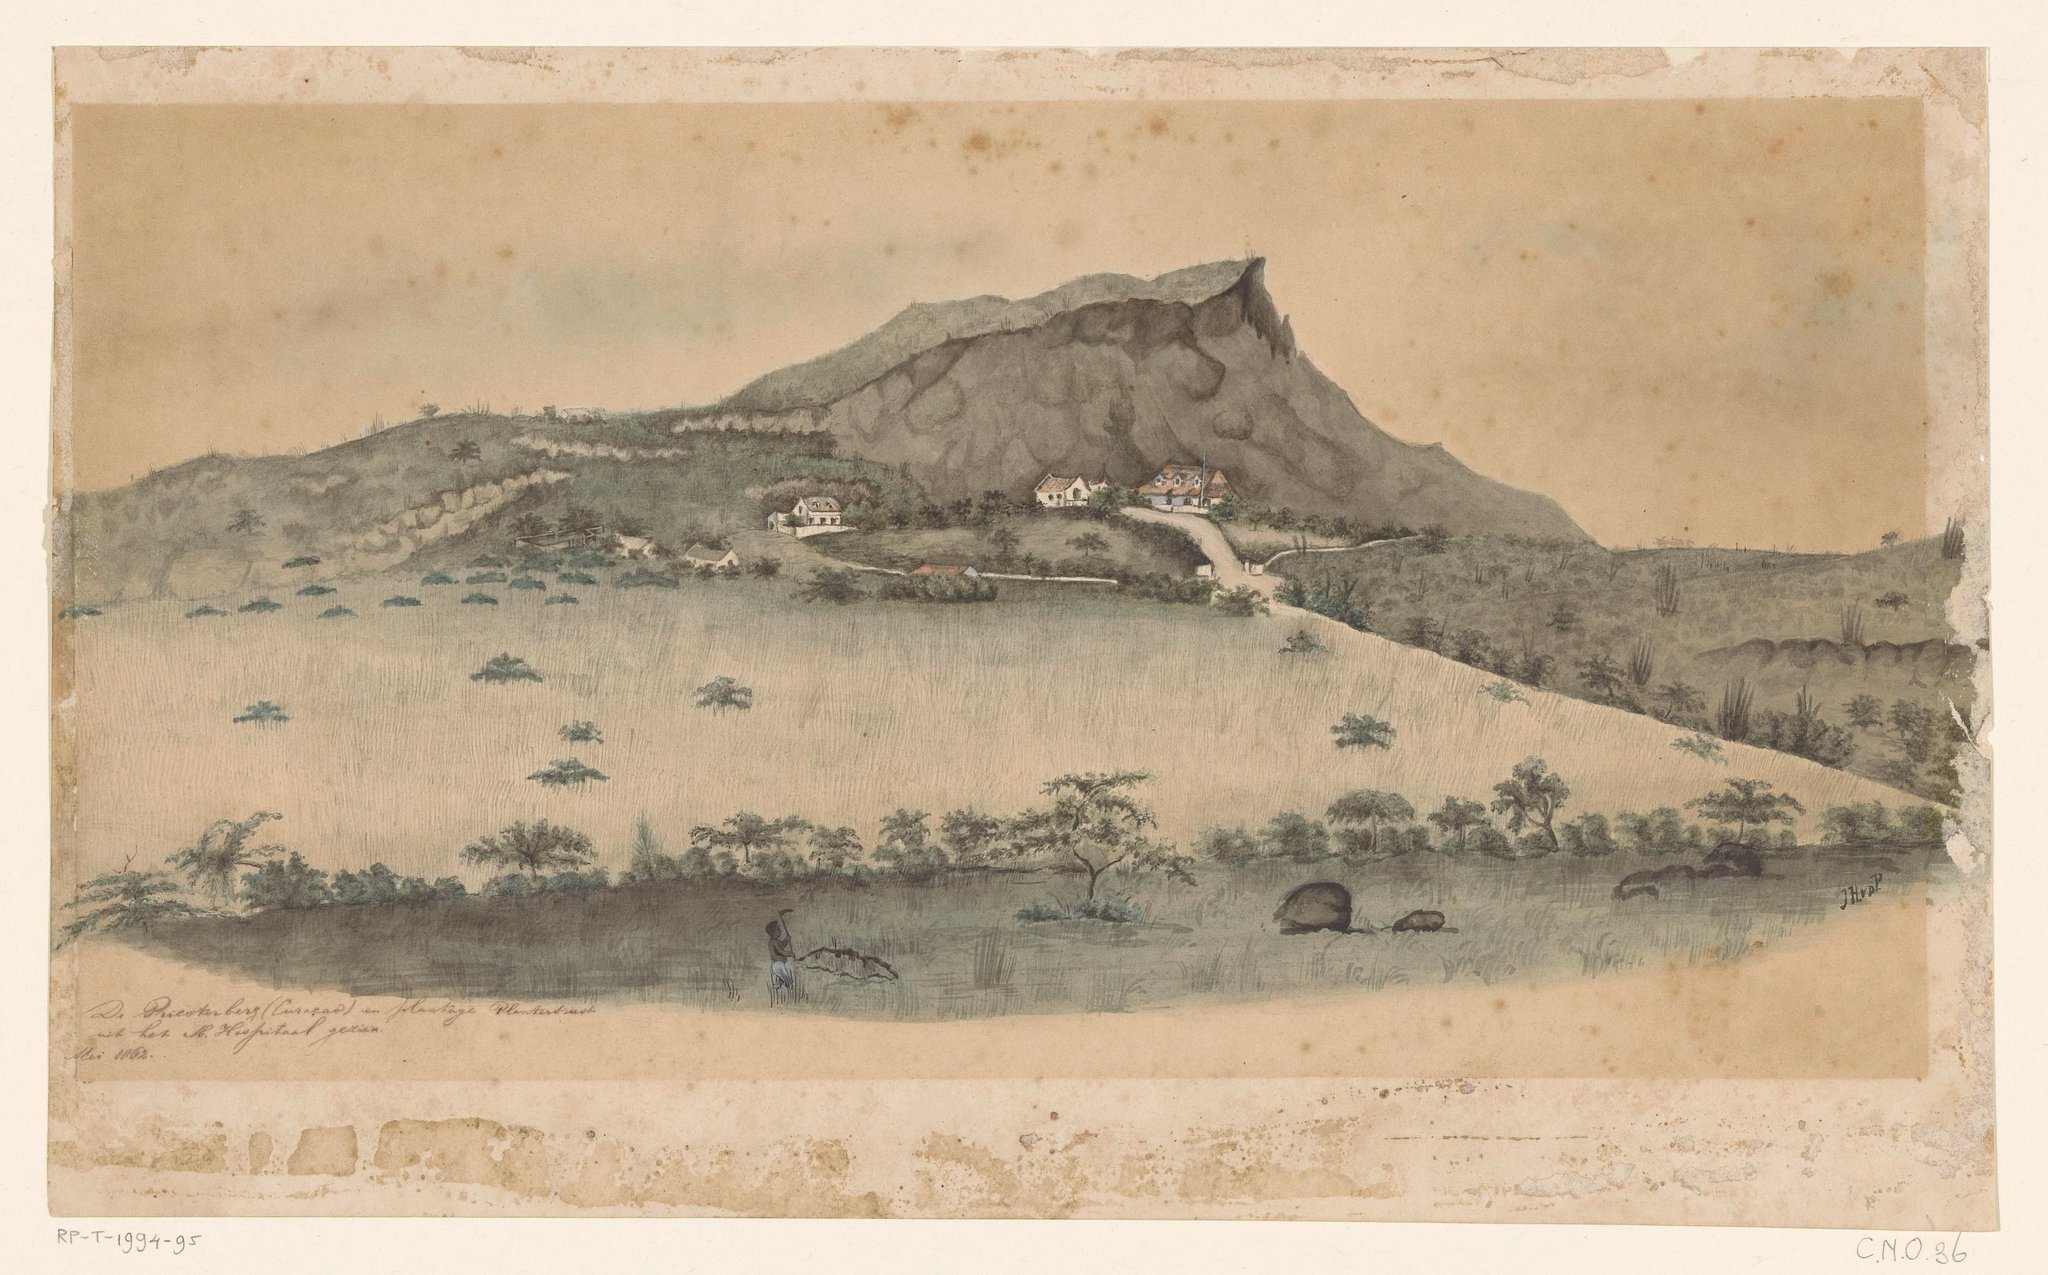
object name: drawing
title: Gezicht op de plantage Plantersrust op Curaçao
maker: jacob hendrik van de poll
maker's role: draughtsman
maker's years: 1843-1863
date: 1805-1862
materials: paint, ink, paper, pencil, watercolor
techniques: brush, pen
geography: curacao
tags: plantation, city-view, and landscape with man-made constructions, mountains, priesterberg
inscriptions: inscription: ‘De Priesterberg (Curaçao) en plantage Plantersrust uit het H. Hospitaal gezien.’